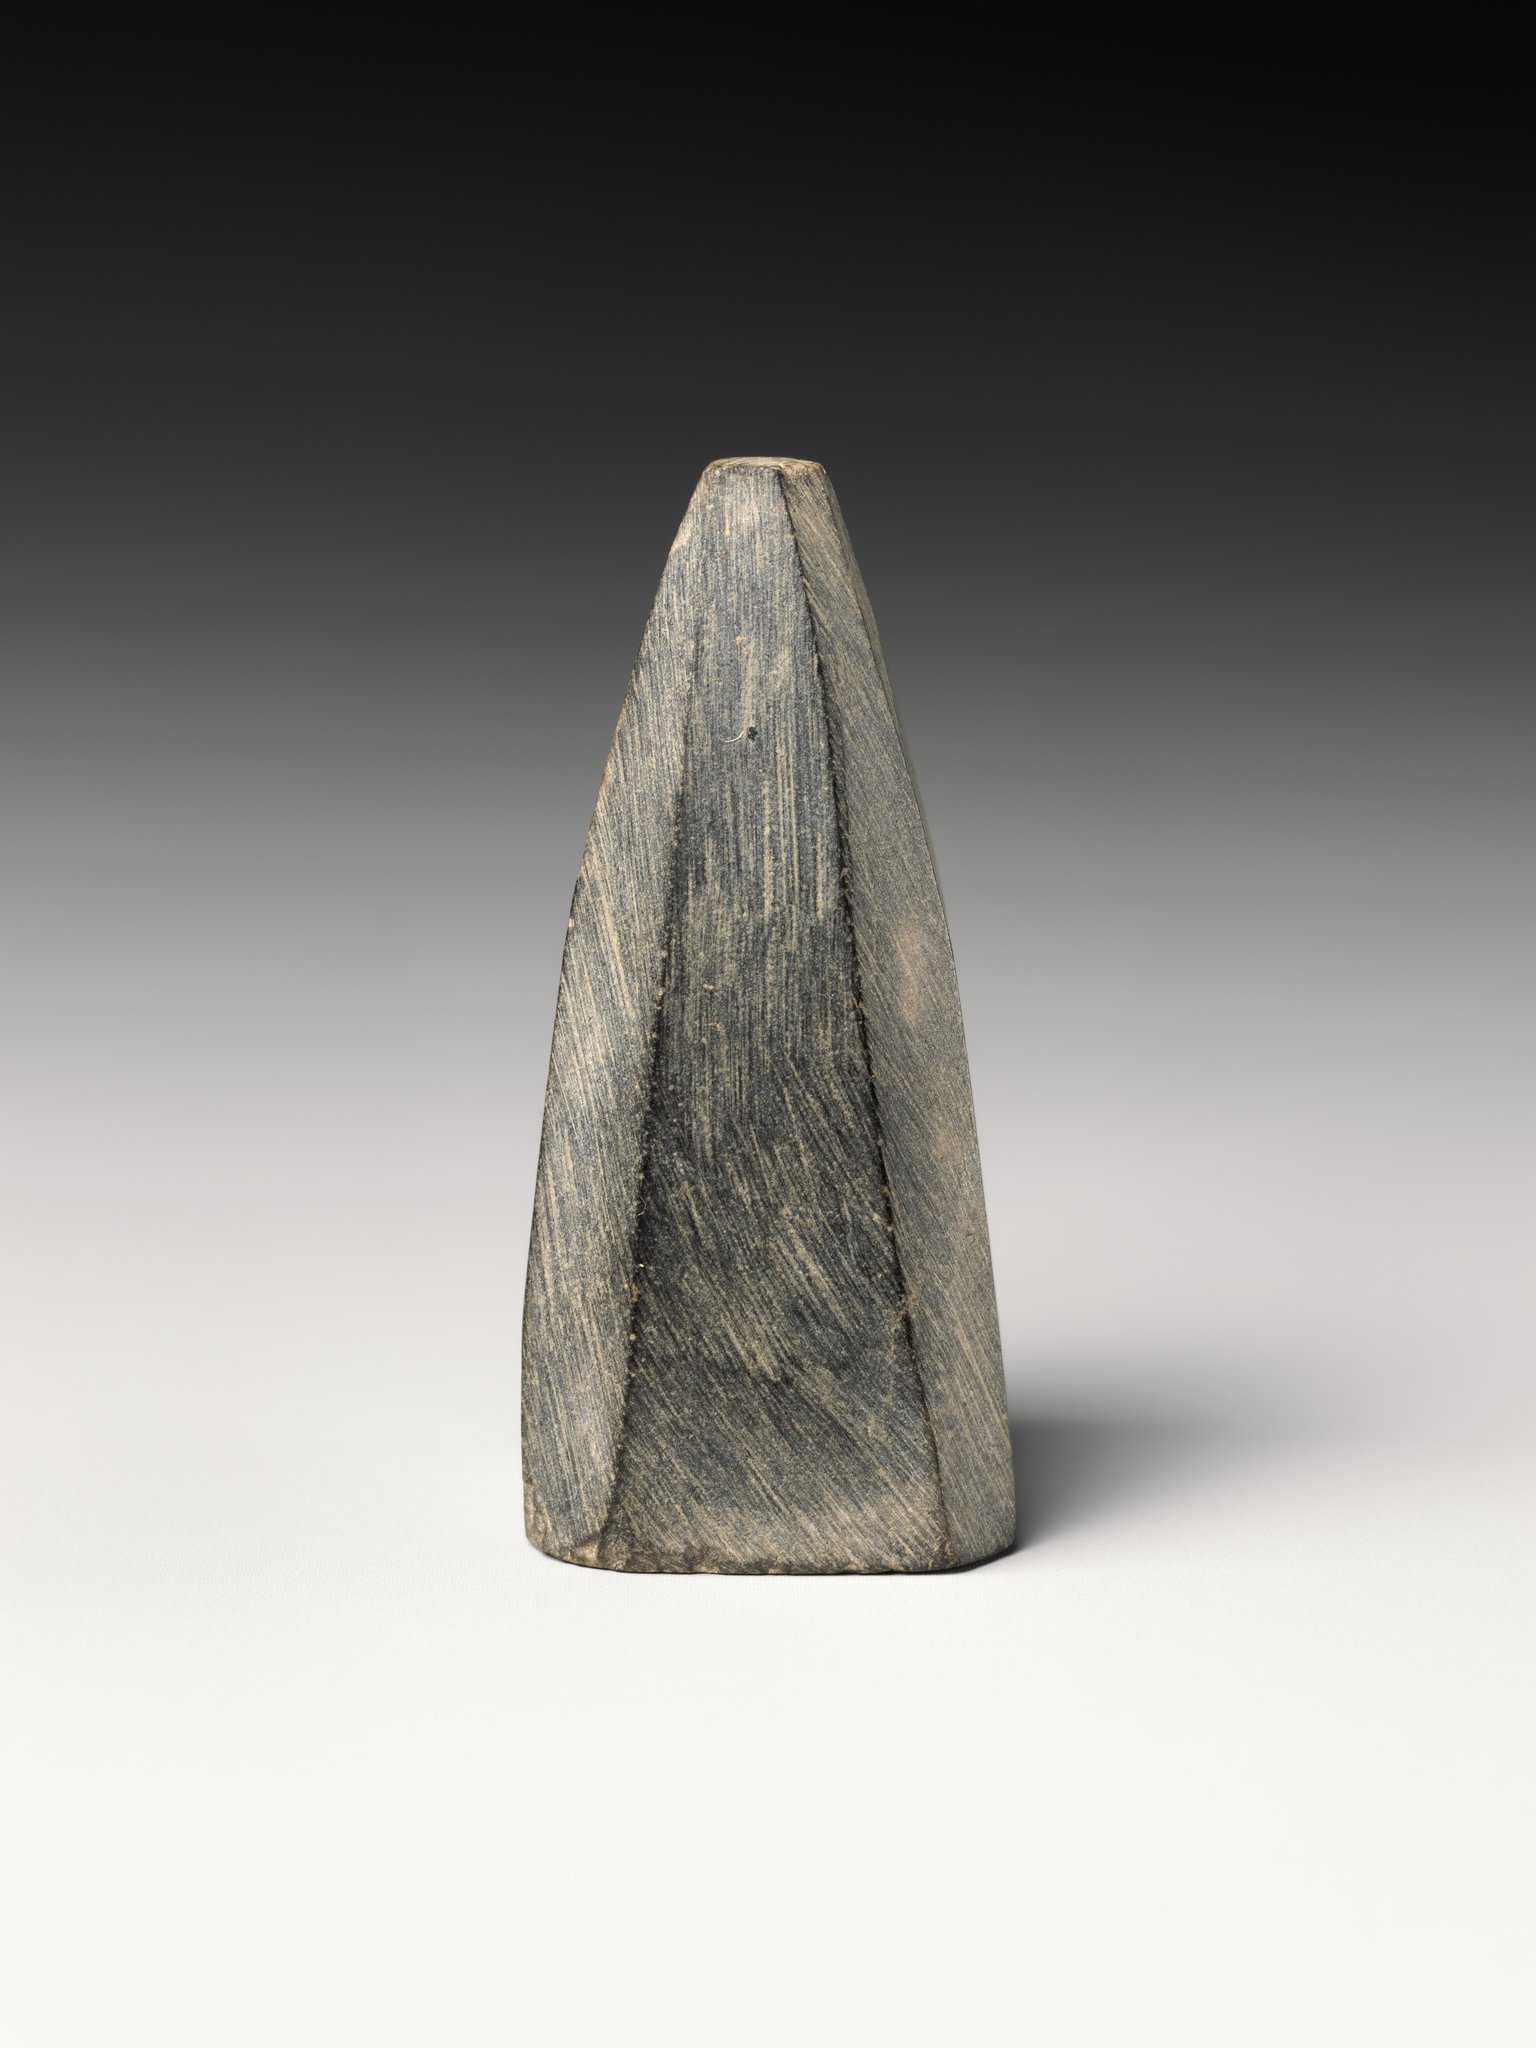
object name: inlay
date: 3100-2900 BCE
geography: mesopotamia